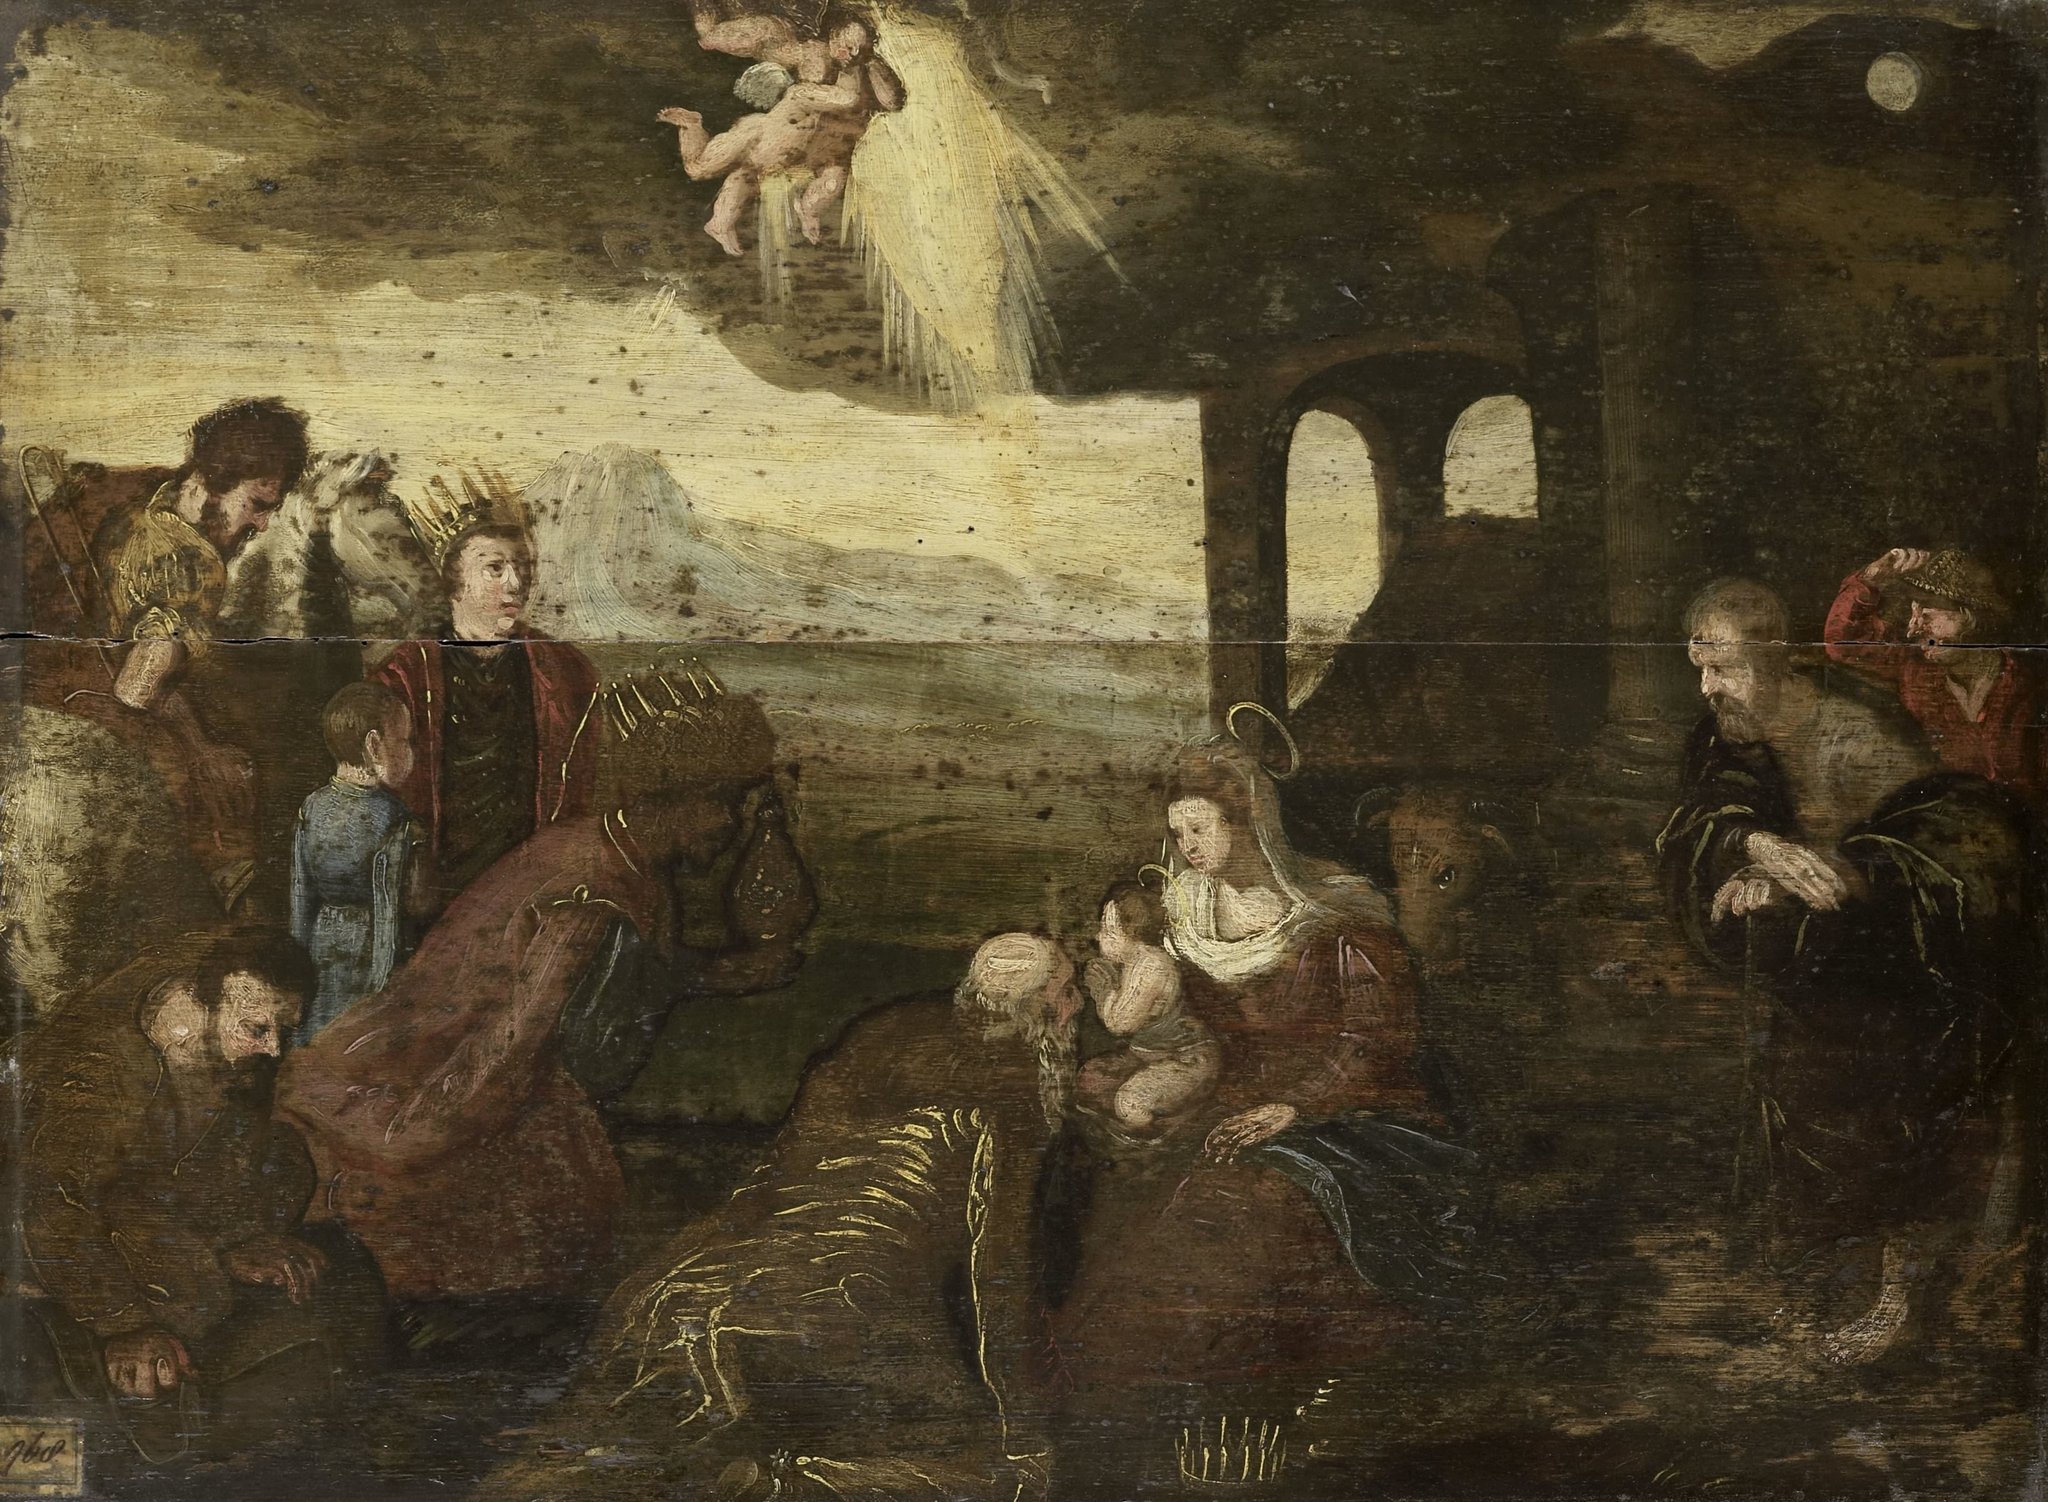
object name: painting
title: Adoration of the Magi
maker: Anonymous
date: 1500-1599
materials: oil, panel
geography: southern netherlands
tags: adoration of the kings: the wise men present their gifts to the christ-child (gold, frankincense and myrrh)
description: De aanbidding der koningen. Een koning knielt in aanbidding bij Maria met het kind, links wachten de andere koningen met geschenken, rechts Jozef en een herder. In de hemel engelen.